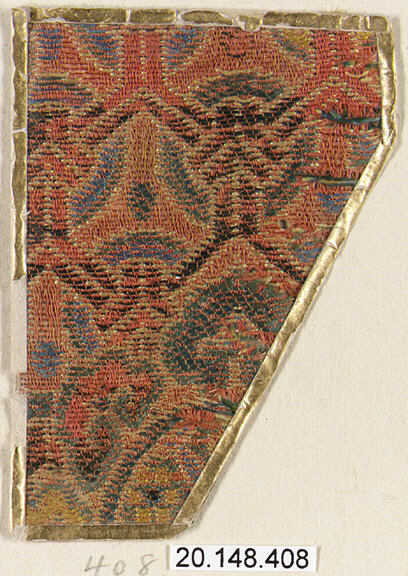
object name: piece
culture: japanese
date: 1801-1900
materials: silk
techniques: compound weave